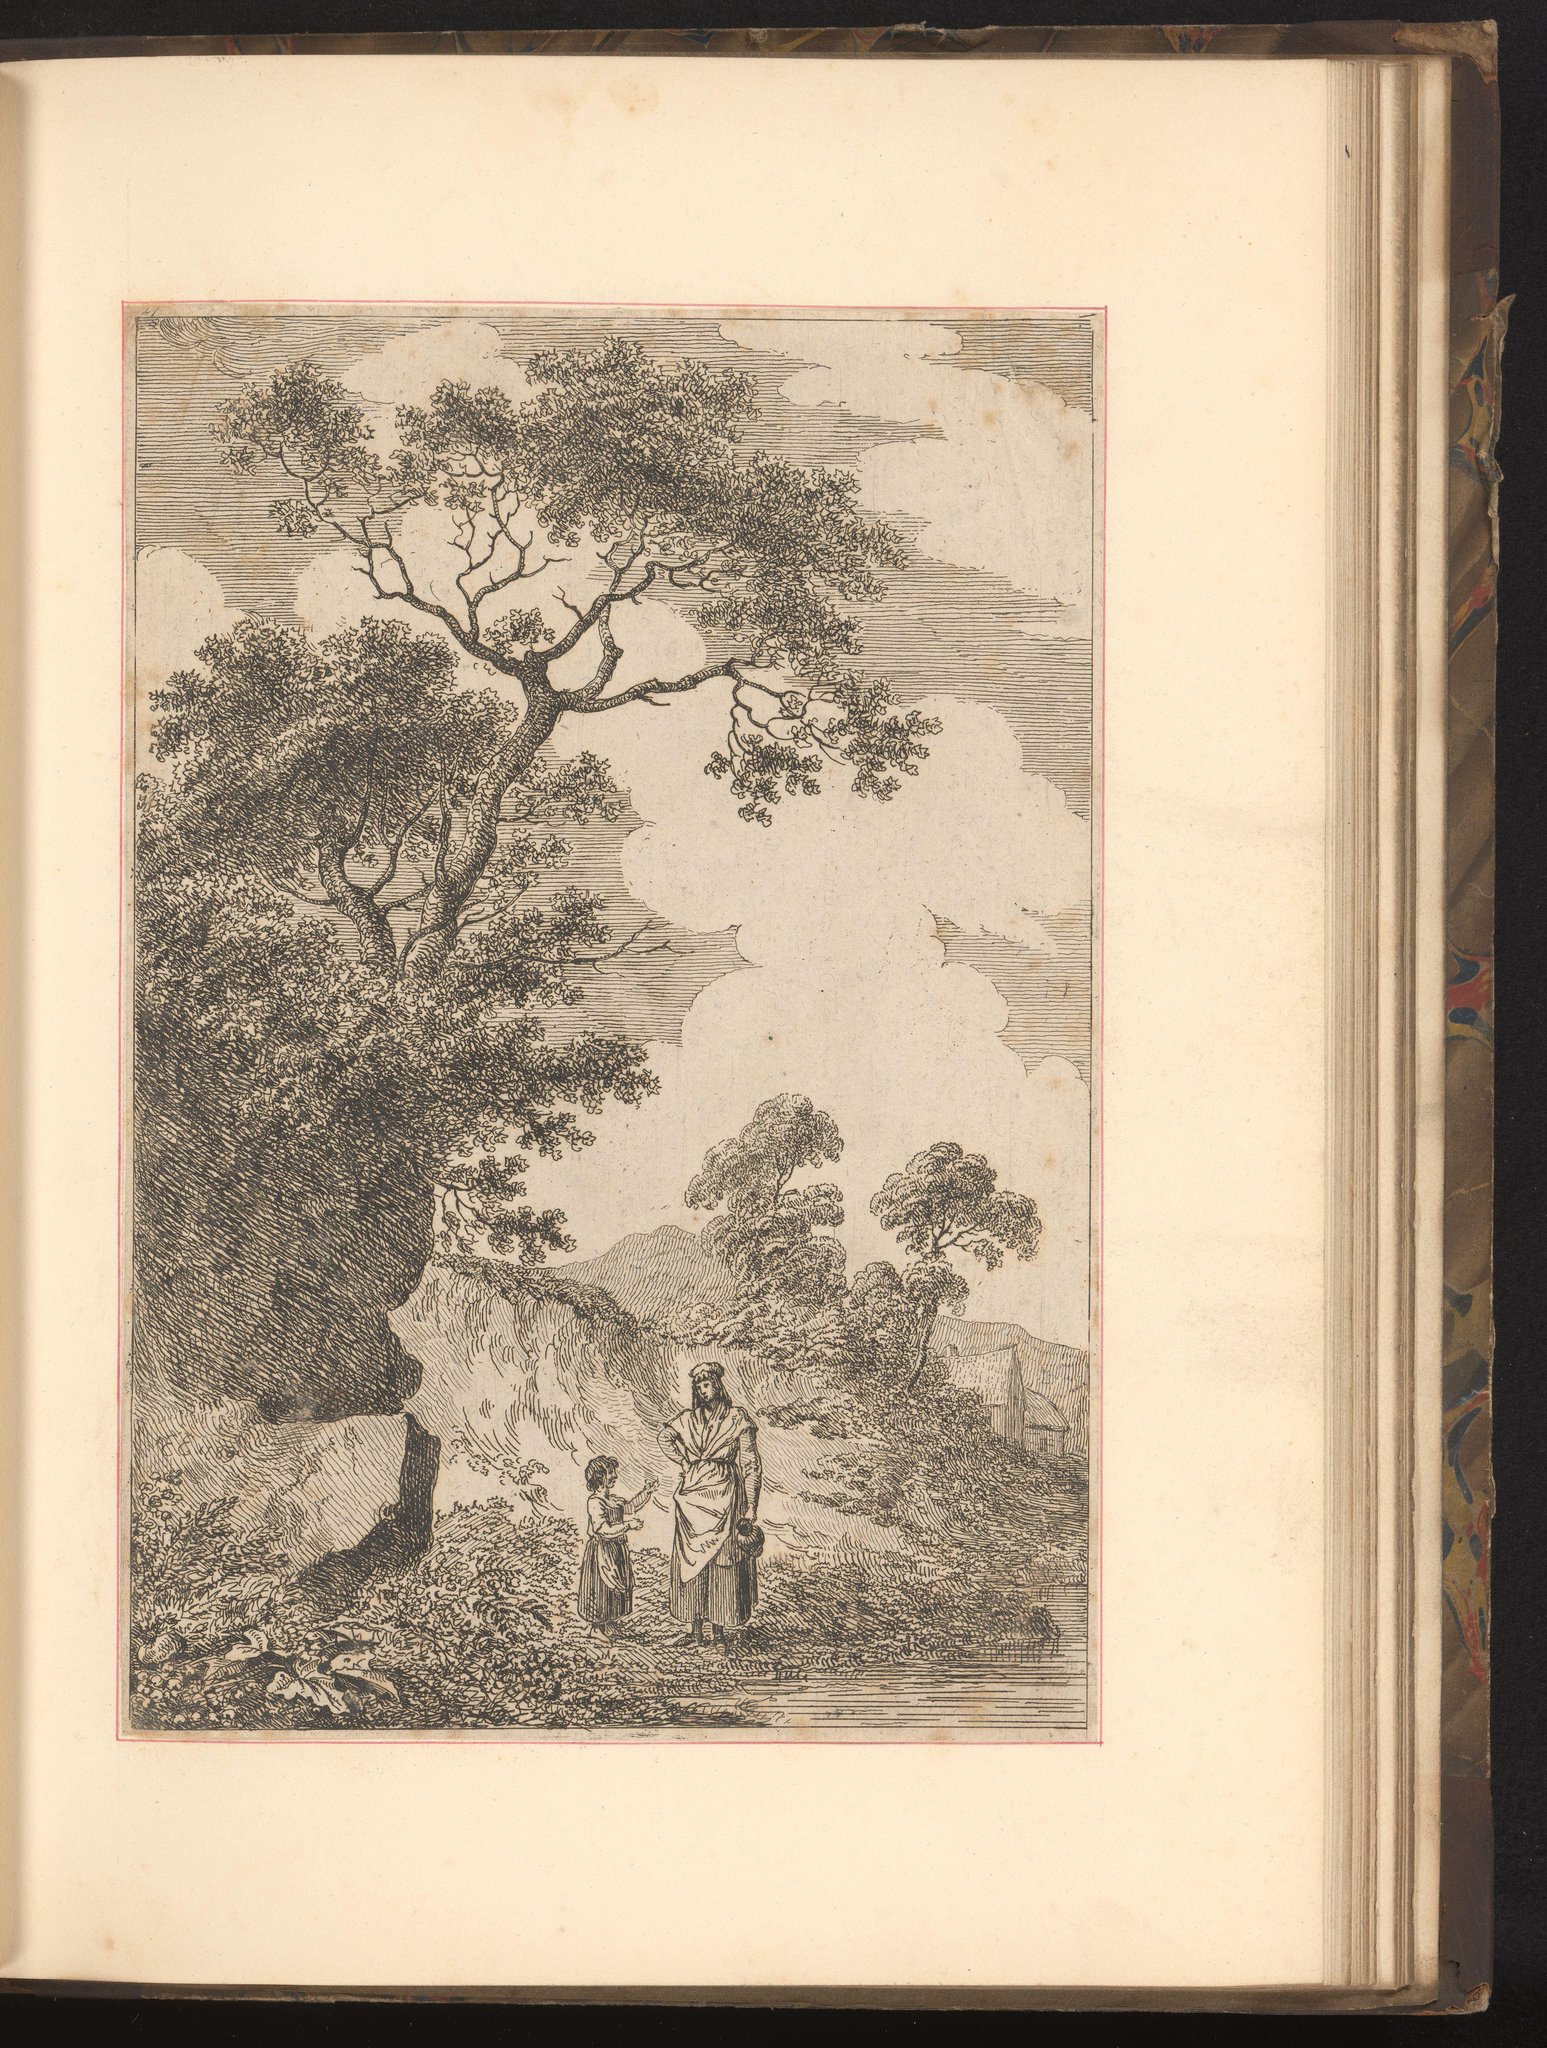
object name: album leaf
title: Etsen door E. Edwards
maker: edward edwards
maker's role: painter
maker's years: 1738-1806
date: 1748-1806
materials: paper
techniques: etching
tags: mother and baby or young child, landscapes (+ landscape with figures, staffage), river bank (+ landscape with figures, staffage)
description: Prent maakt deel uit van een serie van 51 prenten, bestaande uit twee delen met landschappen (36 prenten) en figuren en portretten (15 prenten), voor het eerst uitgegeven in Londen in 1790.